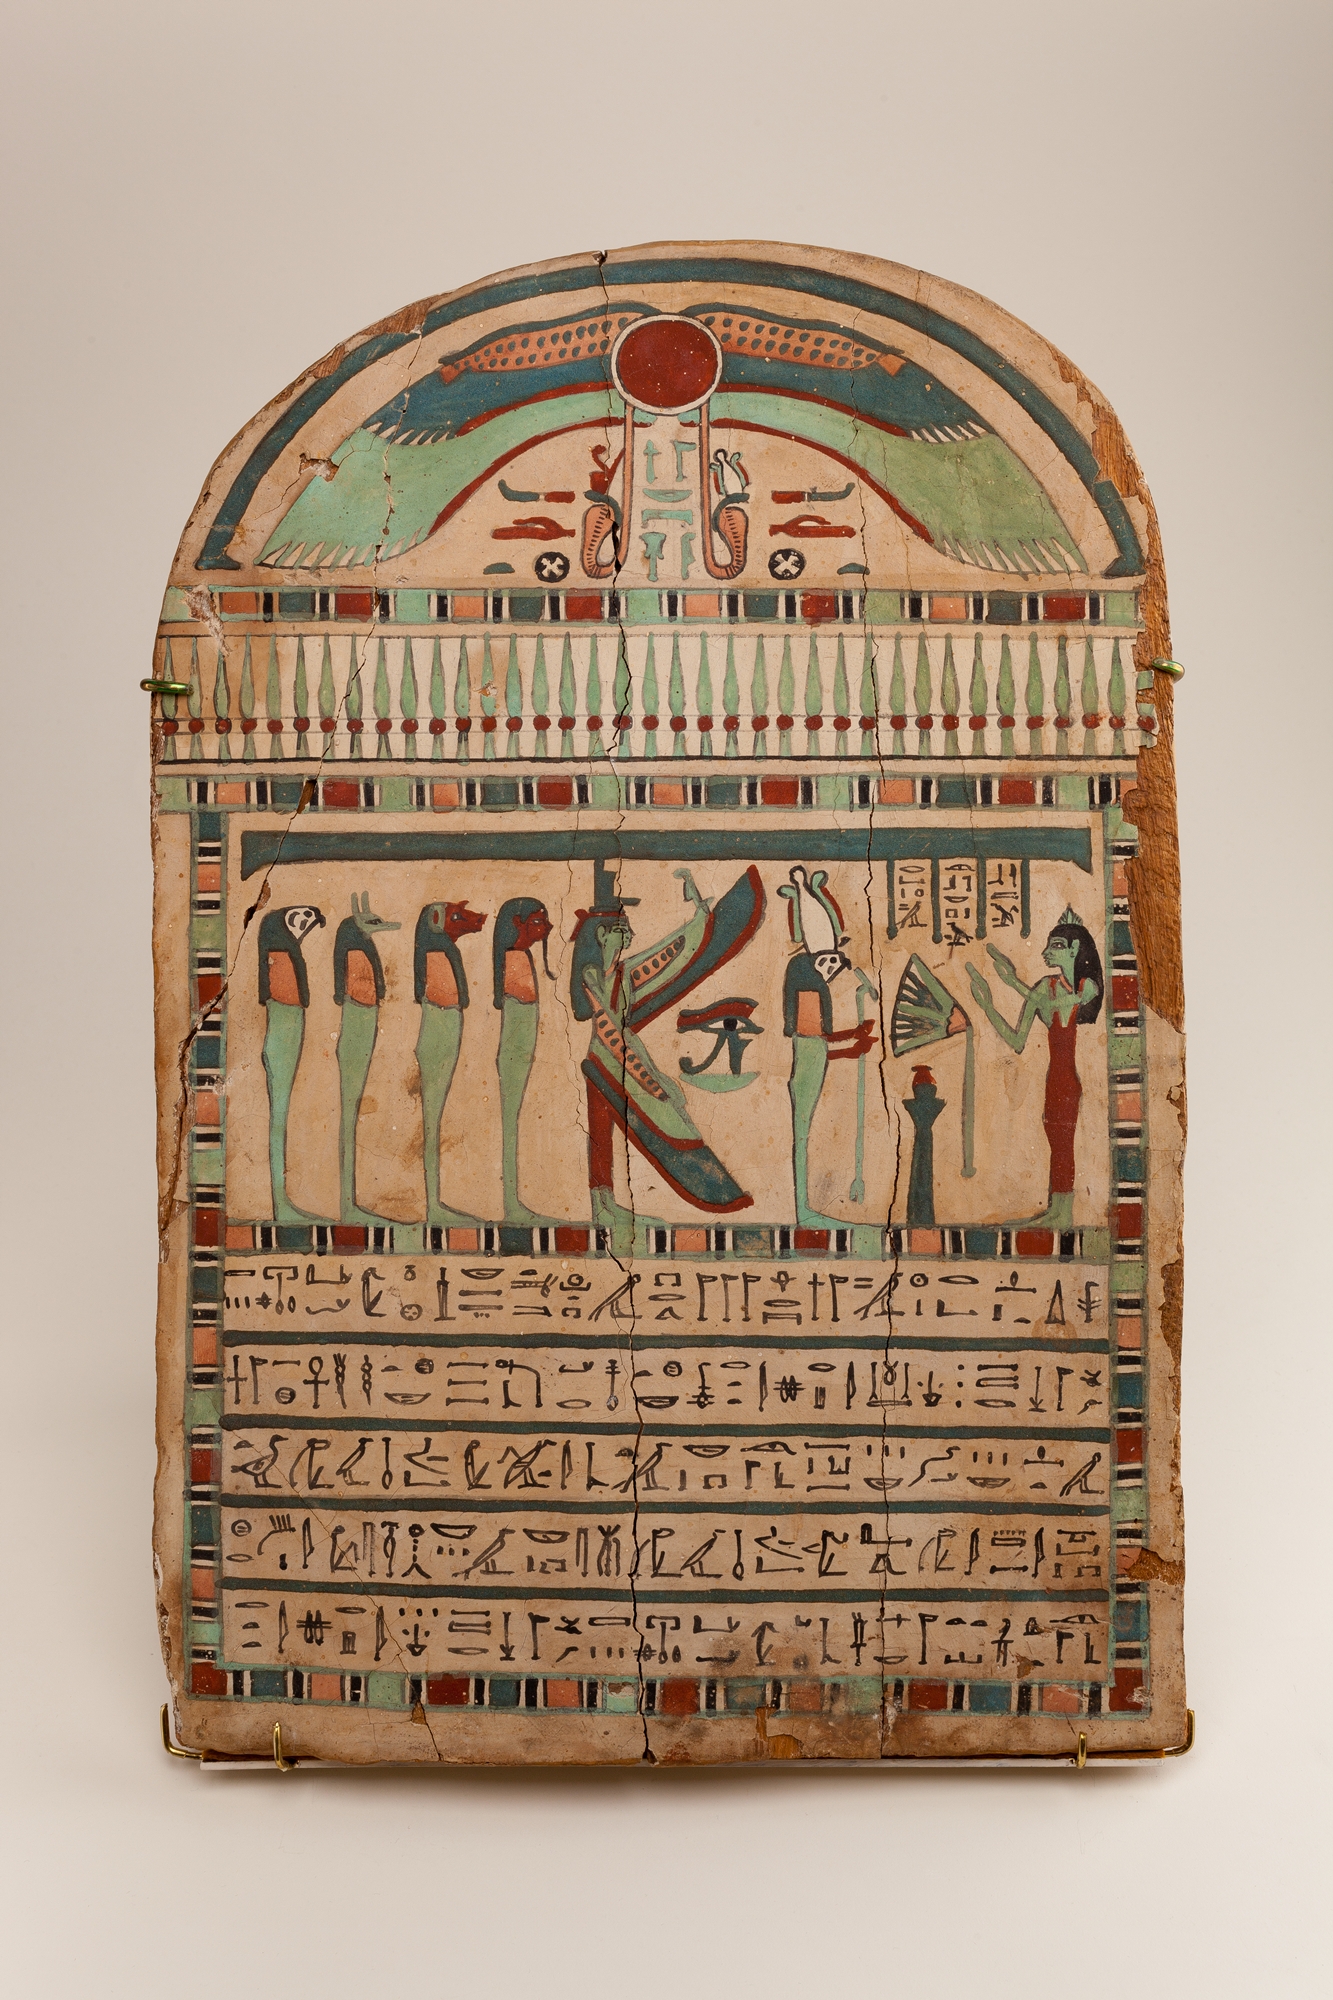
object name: stela, tabiemmut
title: Stela of the Lady of the House, Tabiemmut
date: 750-525 BCE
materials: gesso, paint, wood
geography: egypt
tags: women,hieroglyphs